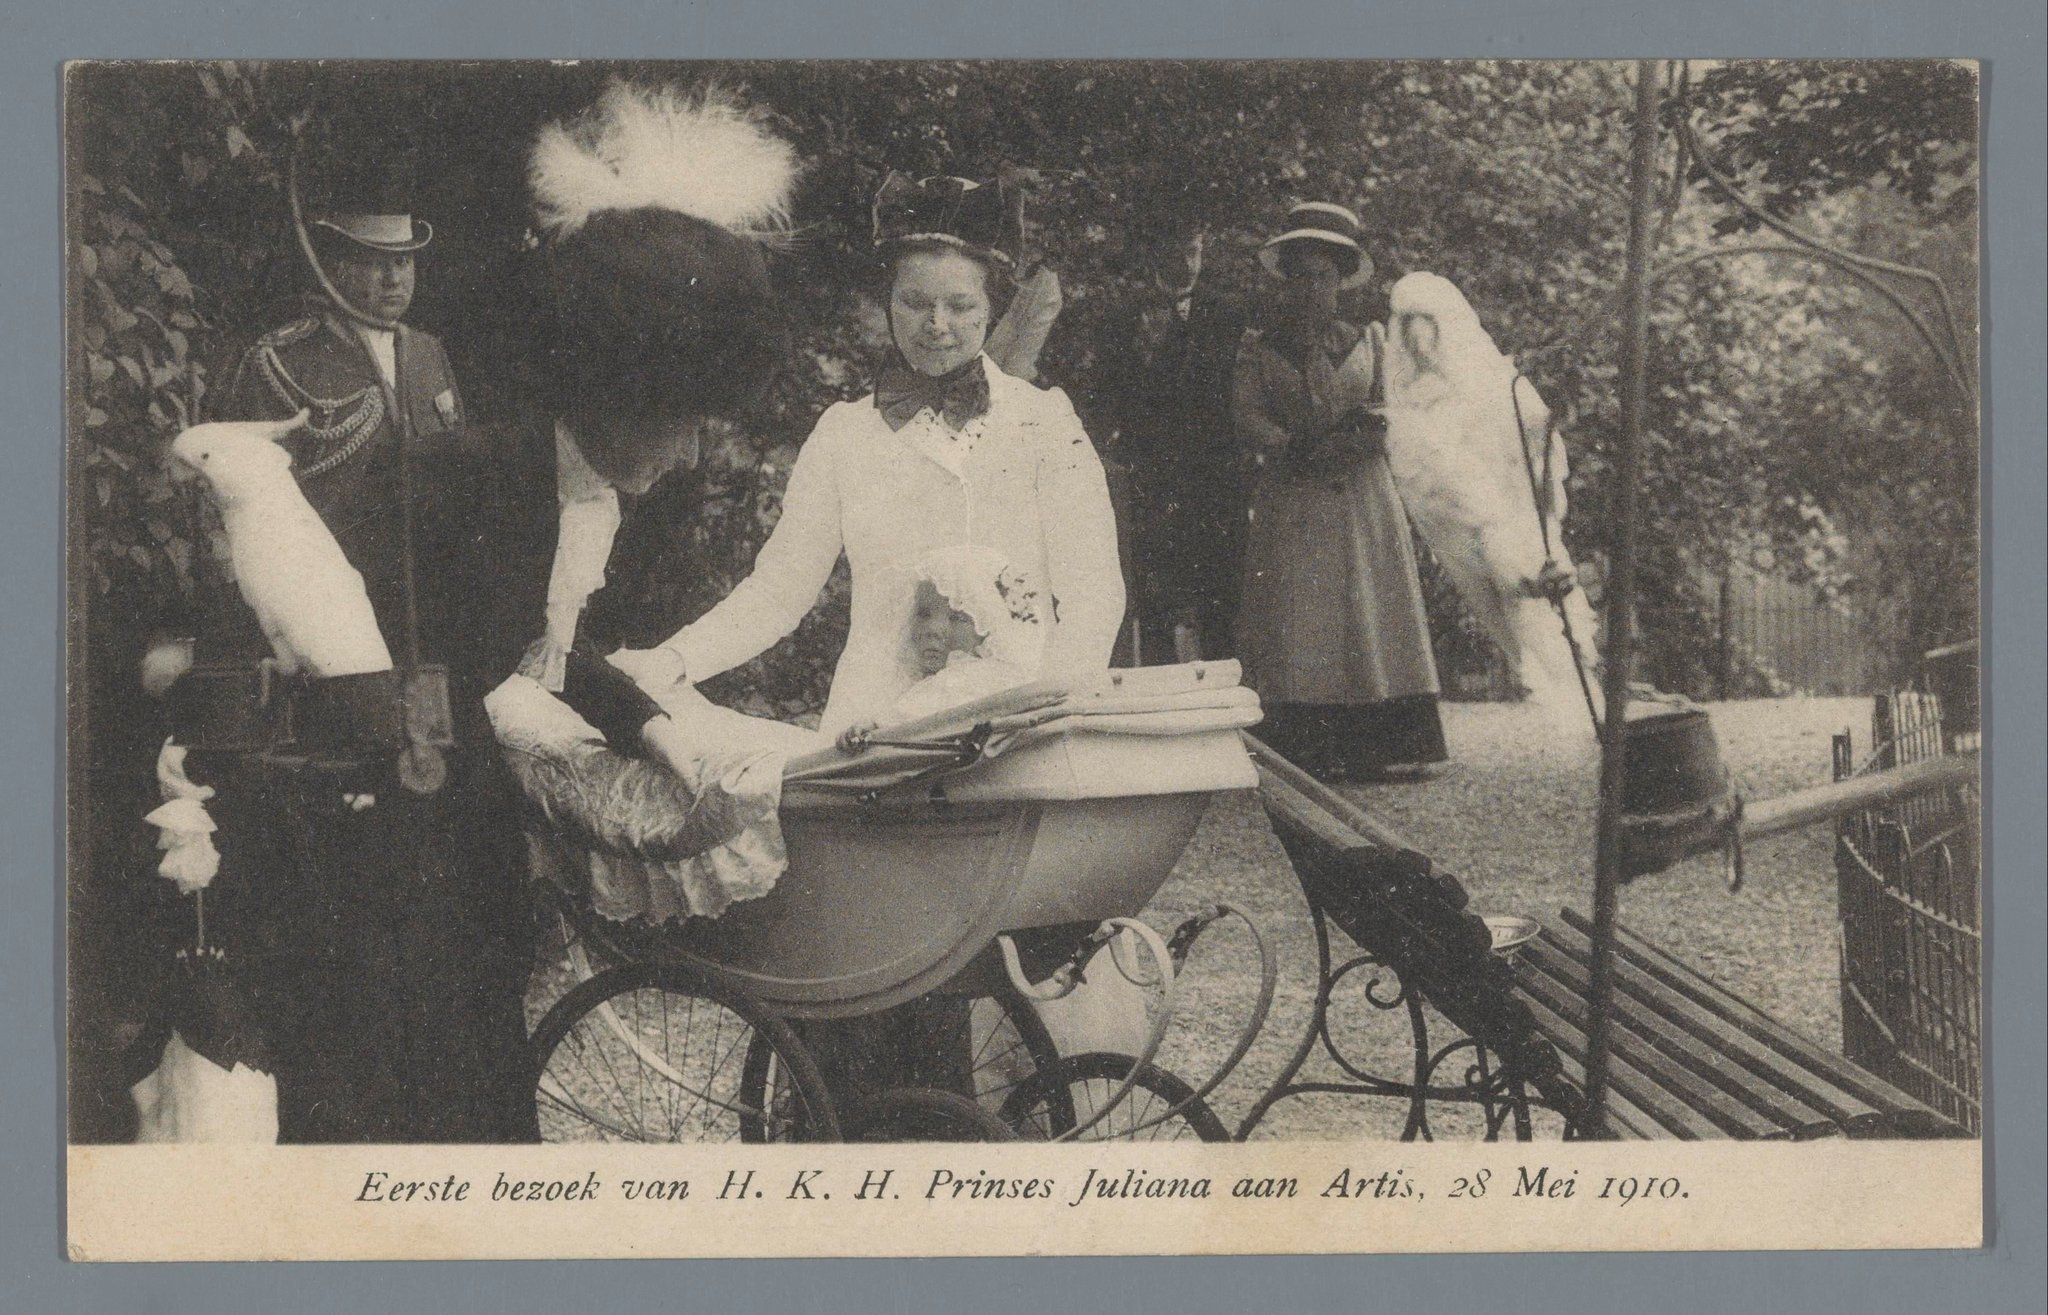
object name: photomechanical print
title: Eerste bezoek van H.K.H. prinses Juliana aan Artis. 28 Mei 1910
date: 1910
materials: cardboard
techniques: photograph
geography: amsterdam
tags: the hague, juliana of the netherlands, crown princess, female infant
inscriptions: postage stamp